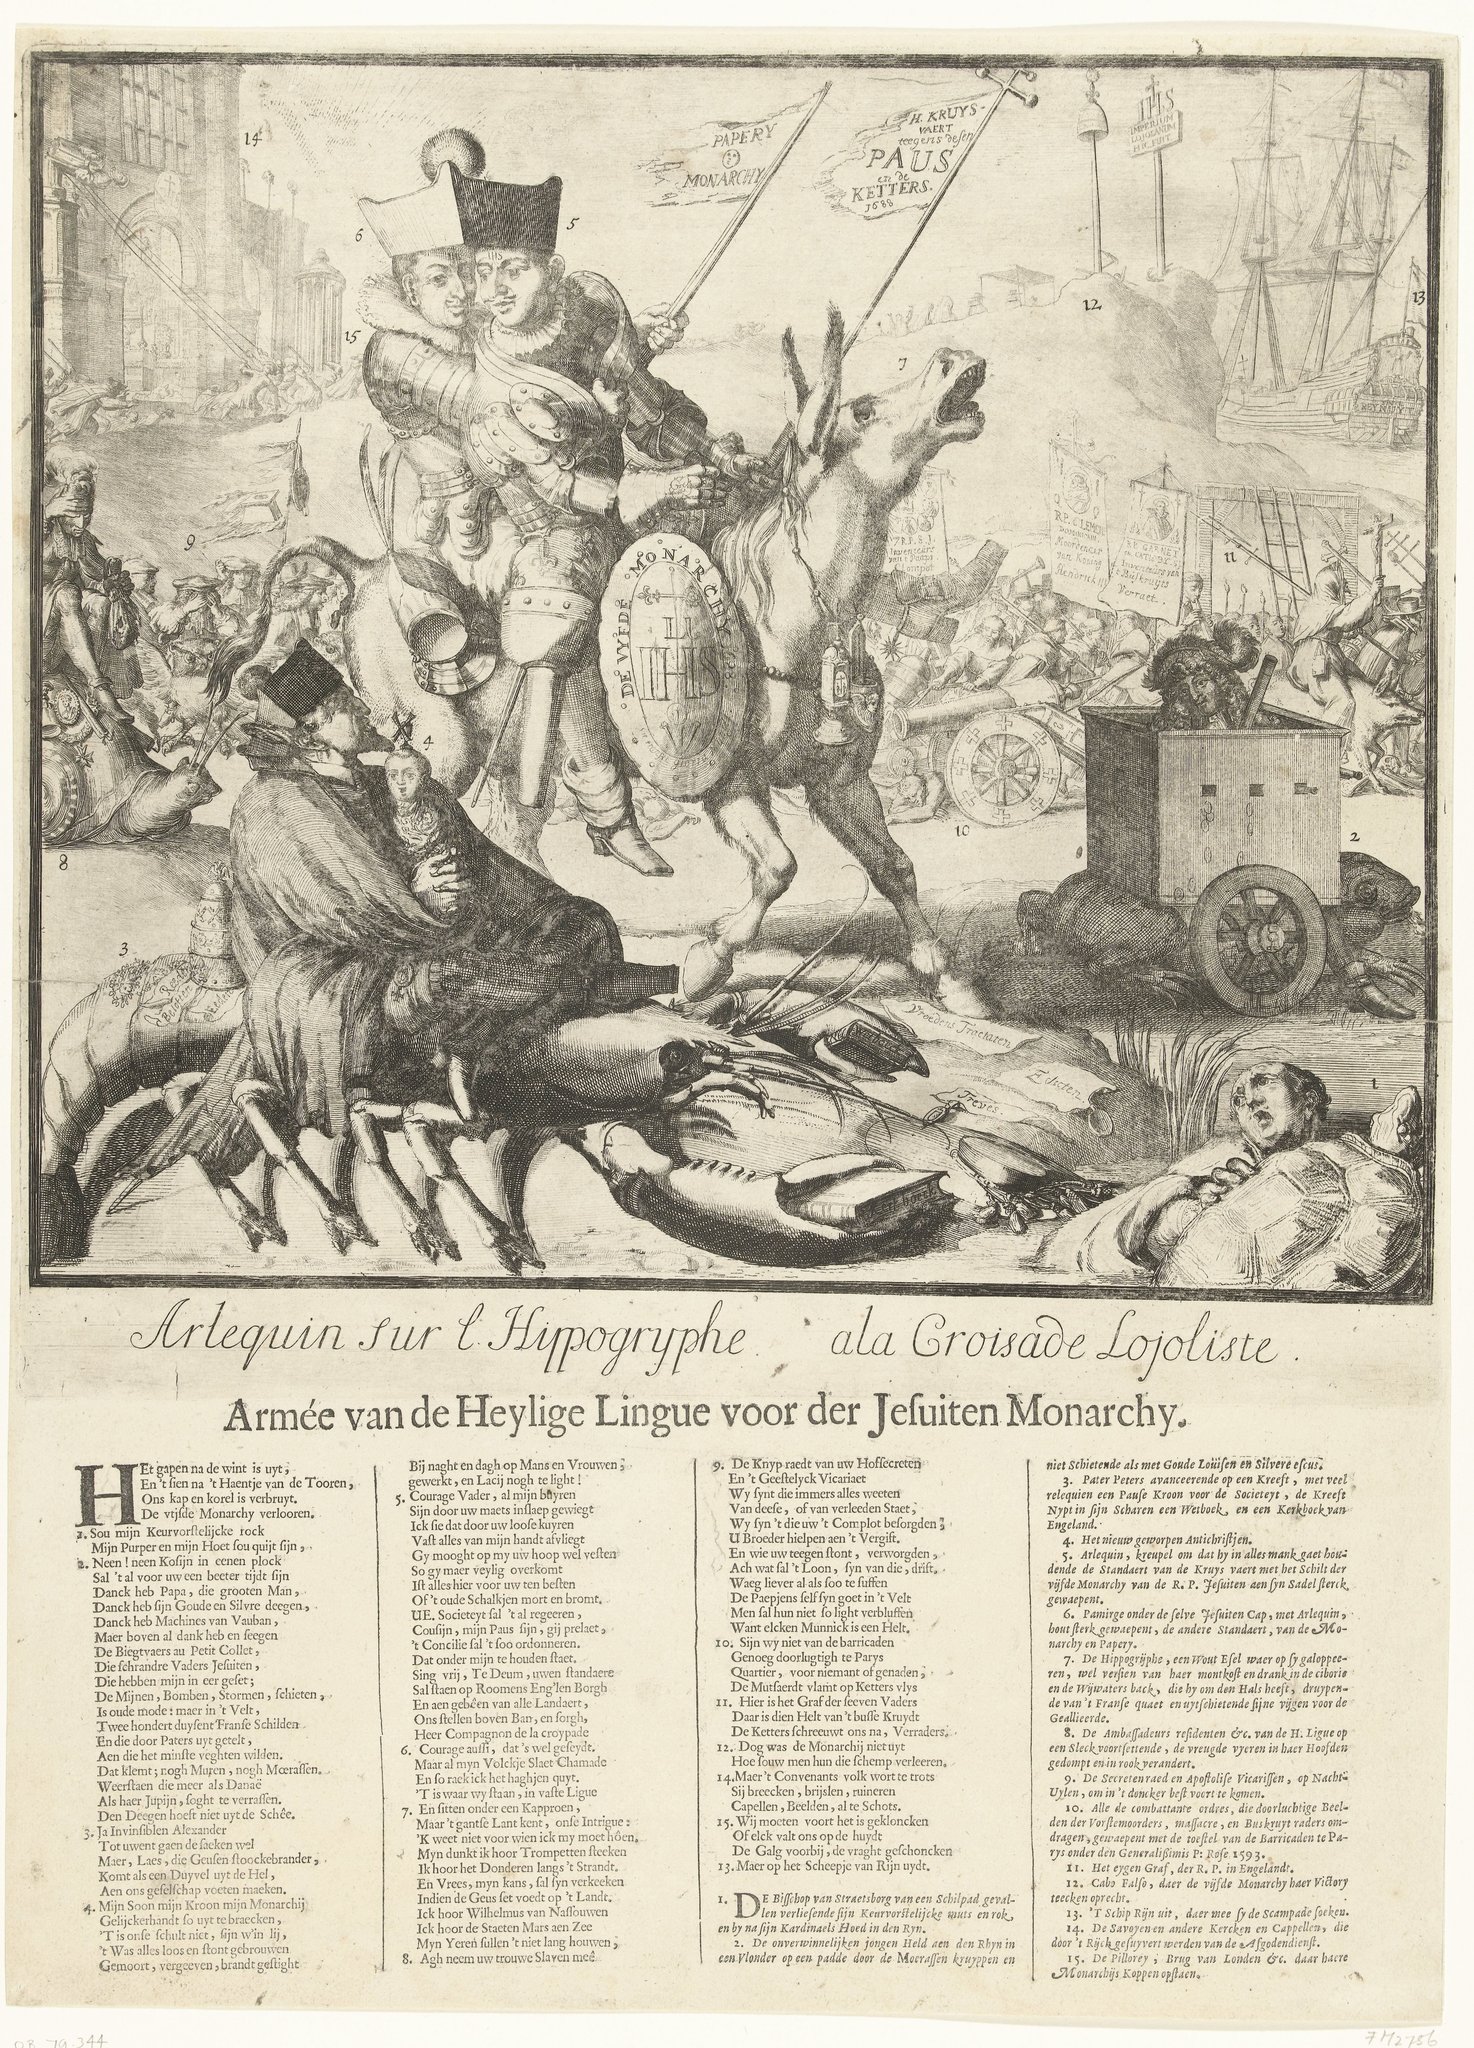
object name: cartoon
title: Spotprenten op Jacobus II en Lodewijk XIV en de gebeurtenissen in de jaren 1688-1689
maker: romeyn de hooghe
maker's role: draughtsman, goldsmith, painter, print maker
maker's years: 1645-1708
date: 1689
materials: paper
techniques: engraving, etching, letterpress printing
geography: northern netherlands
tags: jacobus ii (koning van engeland en schotland), lodewijk xiv (koning van frankrijk), paris, dauphin van frankrijk lodewijk, london, rome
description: Spotprent op de gezamenlijke strijd van de Heilige Liga van Lodewijk XIV en Jacobus II, 1689. Lodewijk XIV (Harlekijn) en Jacobus II (Pamirge) gezeten onder één hoed op een ezel trekken ten strijde tegen de protestanten. Op de voorgrond pater Peters (Edward Petre) met het ondergeschoven kind op een kreeft, rechts de dauphin in een kist op de rug van een pad. Rechtsvoor is de bisschop van Straatsburg van zijn schildpad gevallen. Hun dwaze strijd wordt gepresenteerd als een jezuïetische kruistocht. Rechts op de achtergrond ligt het schip Reynuyt (Rijn uit) klaar voor vertrek. Onder de voorstelling 2 verzen in 4 kolommen met een toelichting op de nummers 1-12 in het Nederlands.